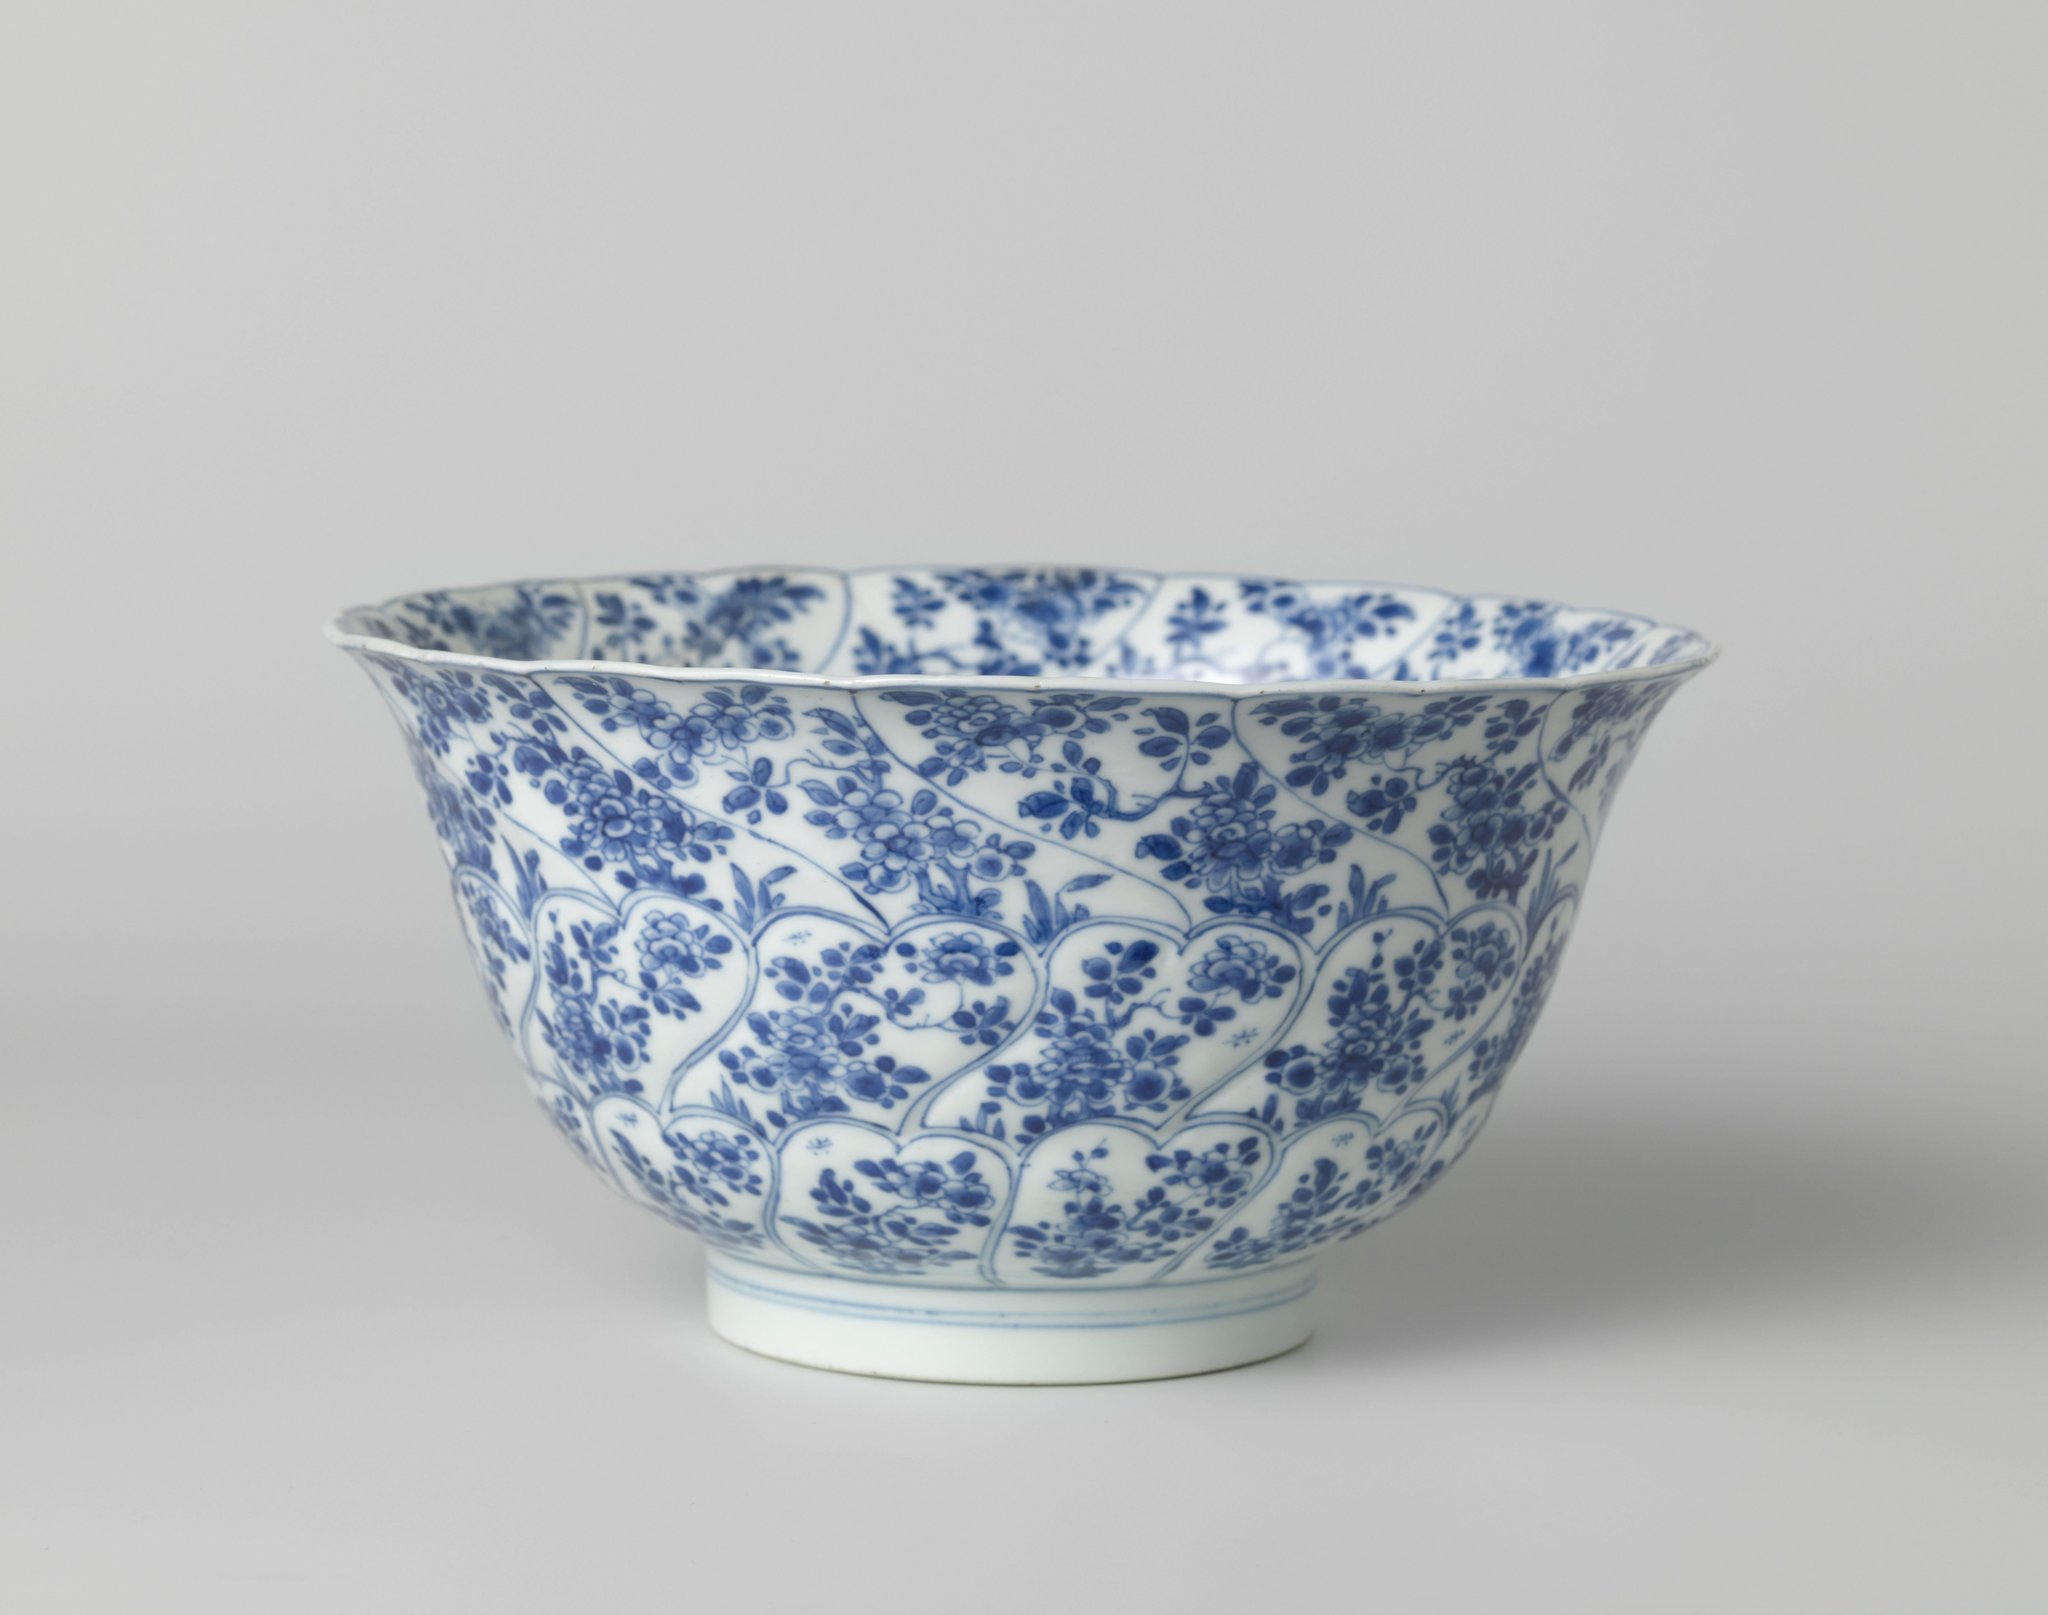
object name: bowl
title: Bowl with three rows of twisted panels with flower sprays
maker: Anonymous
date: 1680-1720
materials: cobalt, glaze, paint, porcelain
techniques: firing, turning, vitrification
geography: china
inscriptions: mark: ‘玉’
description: Kom van porselein met blauw decor. Twee rijen verhoogde schuine vakken omlijst door blauwe randen waarop telkens een tak met kleine bloemen en bladeren. Langs de mondrand die enigszins omgebogen en geschulpt is, zijn zowel binnen als buiten schuine takken in blauw aangebracht. Binnen de kom onder de blauwe rand twee rijen onversierde verdiepte vakken. Op de bodem in een dubbele cirkel een bloeiende struik en een kleine bamboeplant. Korte cilindrische voet met twee blauwe lijnen.